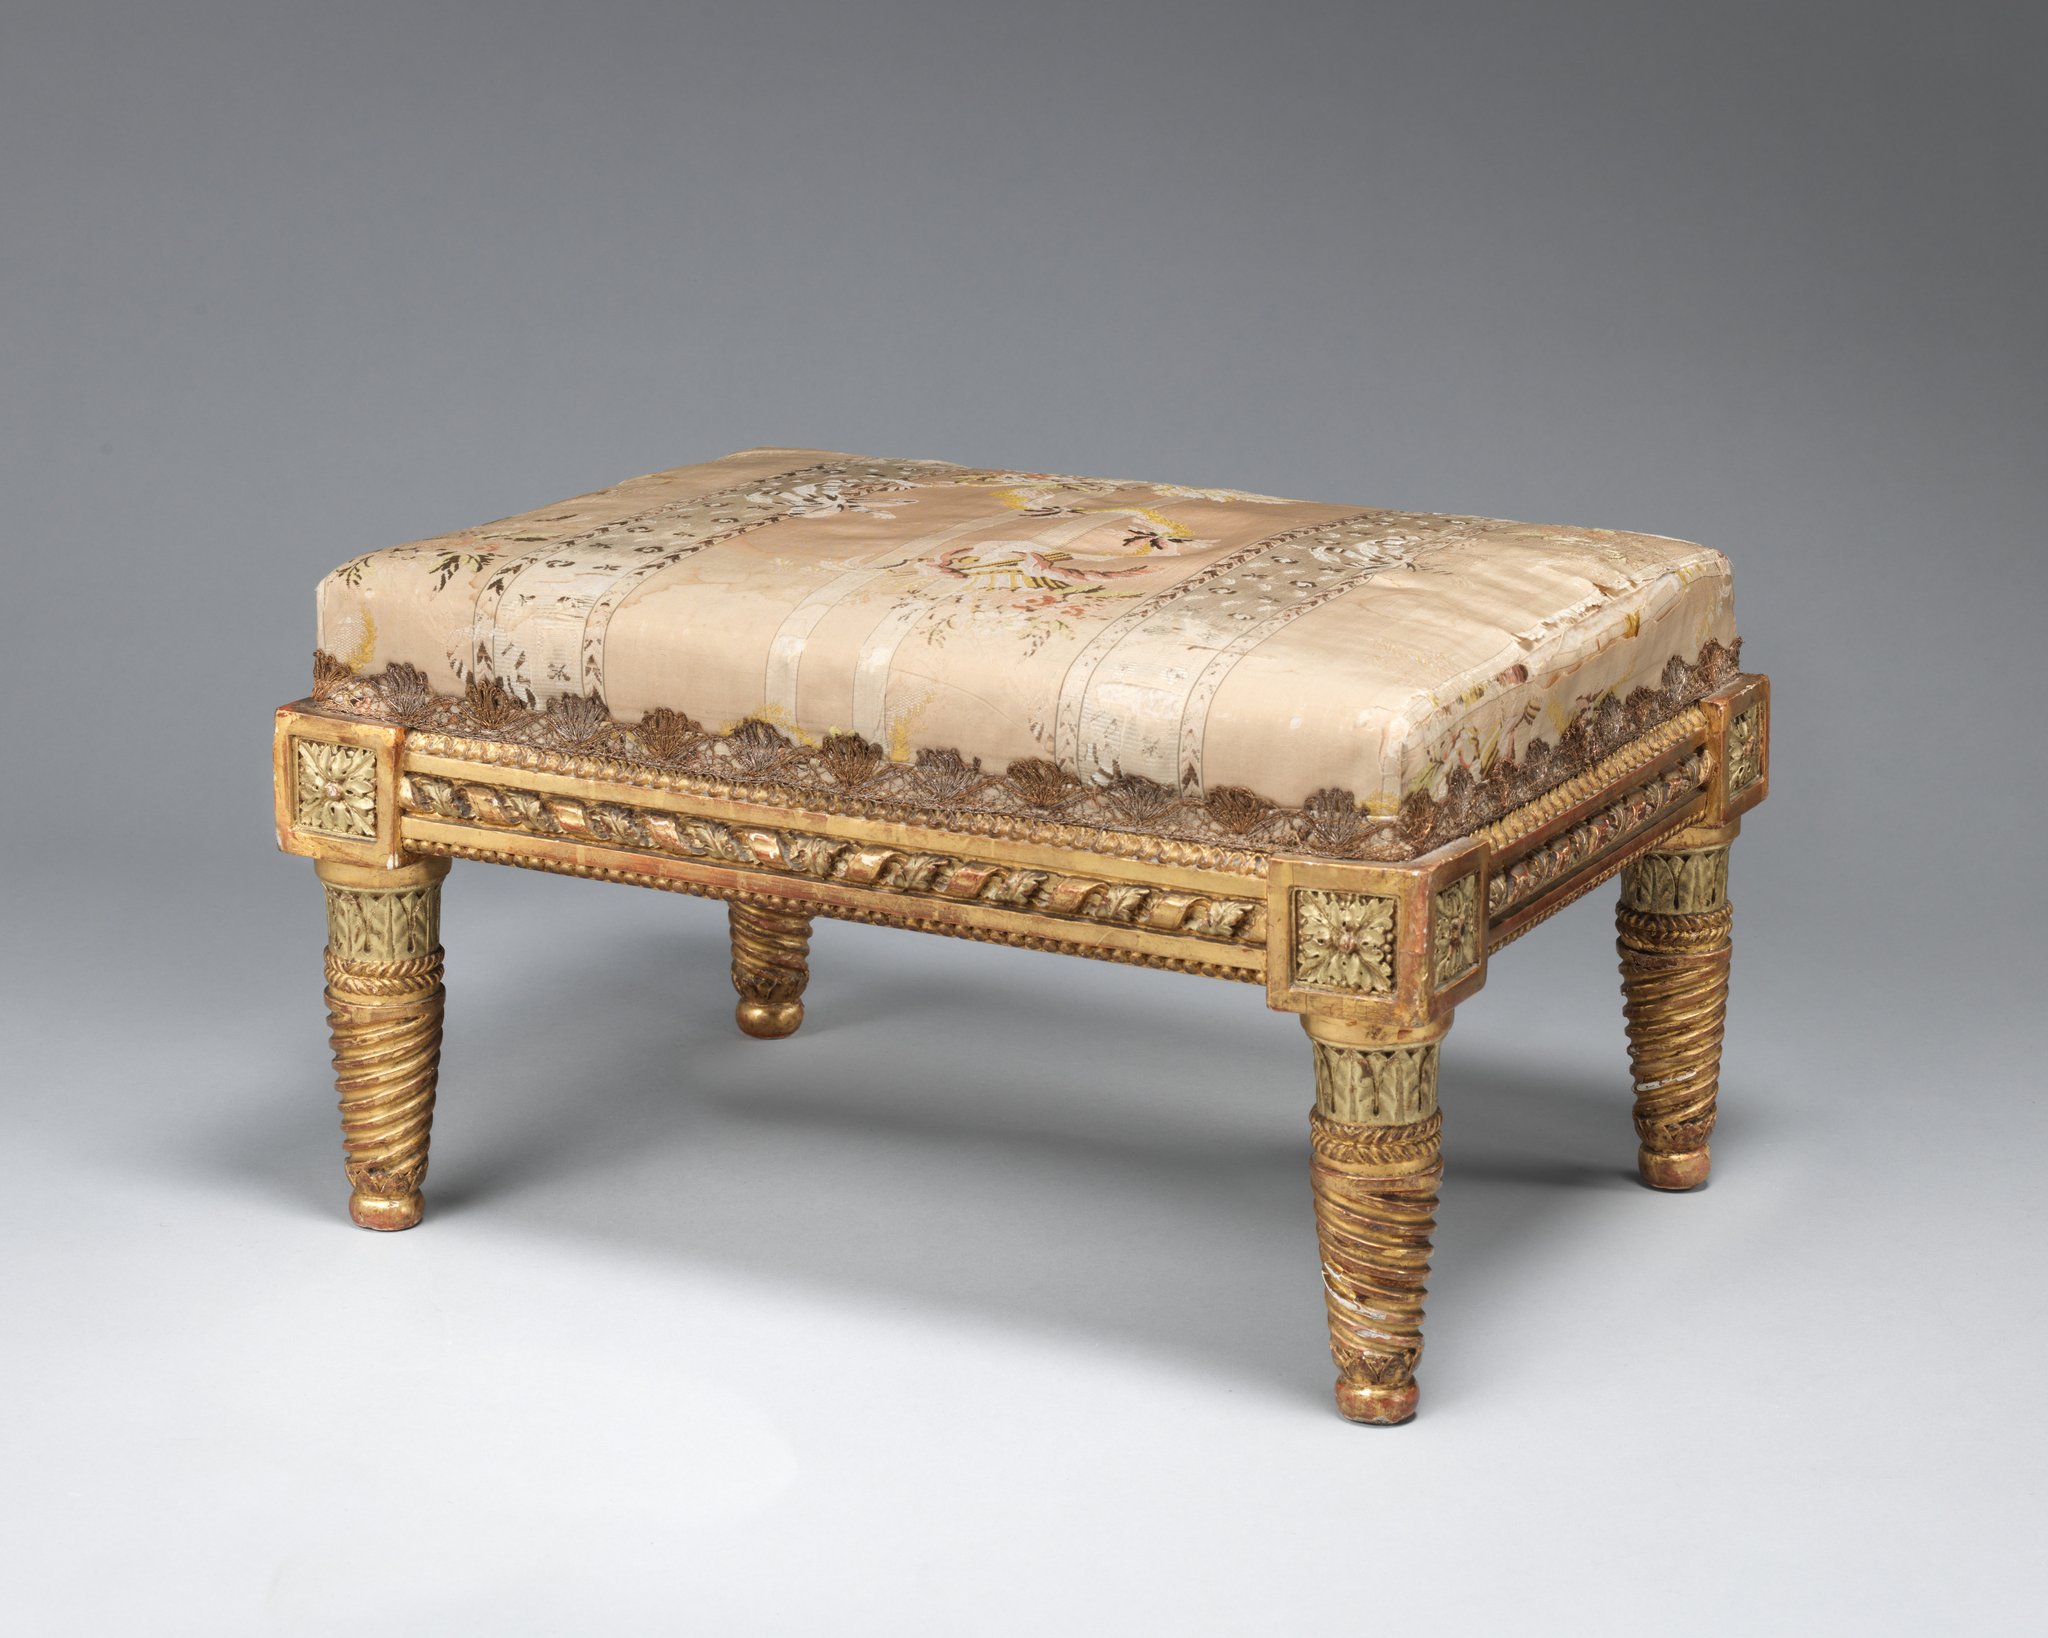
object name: stool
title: Foot stool (bout de pied)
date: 1780-1785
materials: wood, silk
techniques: carving, gilding